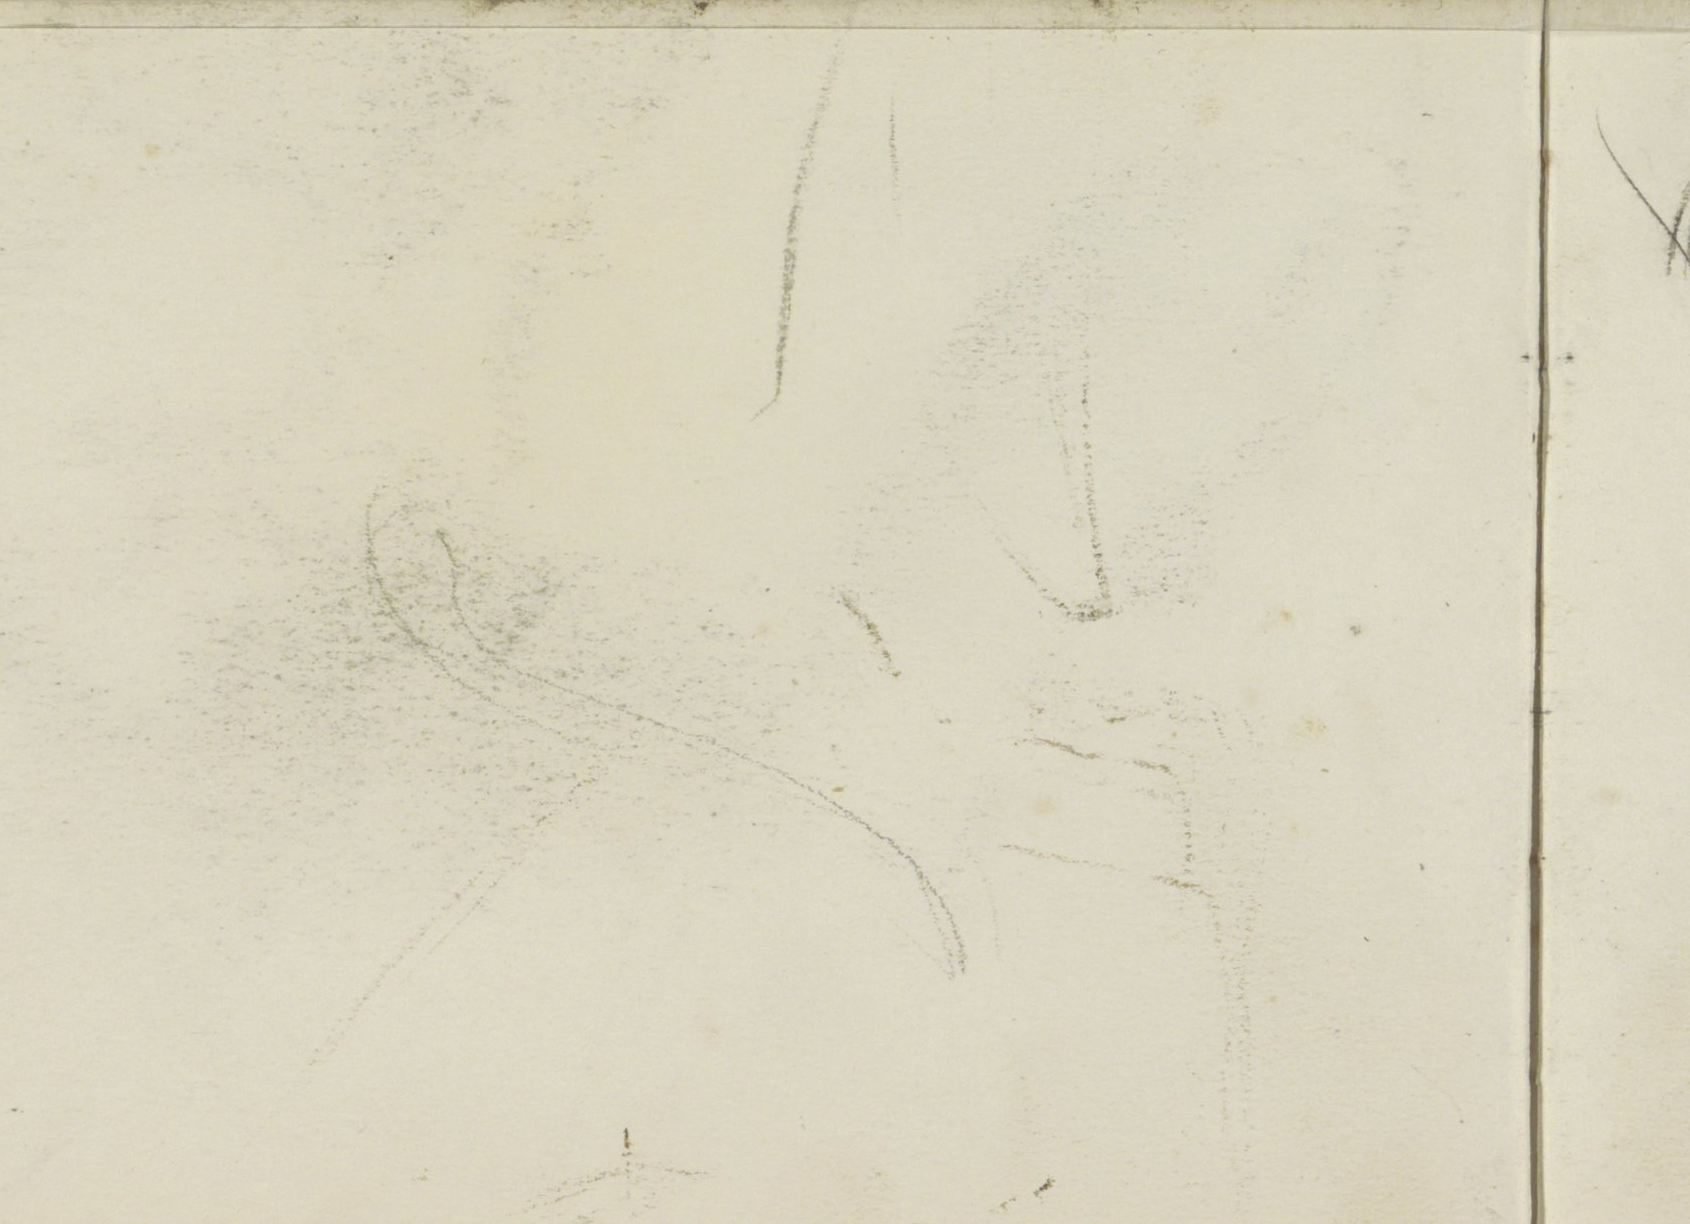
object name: sketchbook leaf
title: Studie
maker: a.a.l. de grammont-hubrecht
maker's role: draughtsman, painter, print maker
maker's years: 1855-1913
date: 1865-1913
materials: chalk, paper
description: Blad 16 verso uit een schetsboek met 38 bladen.